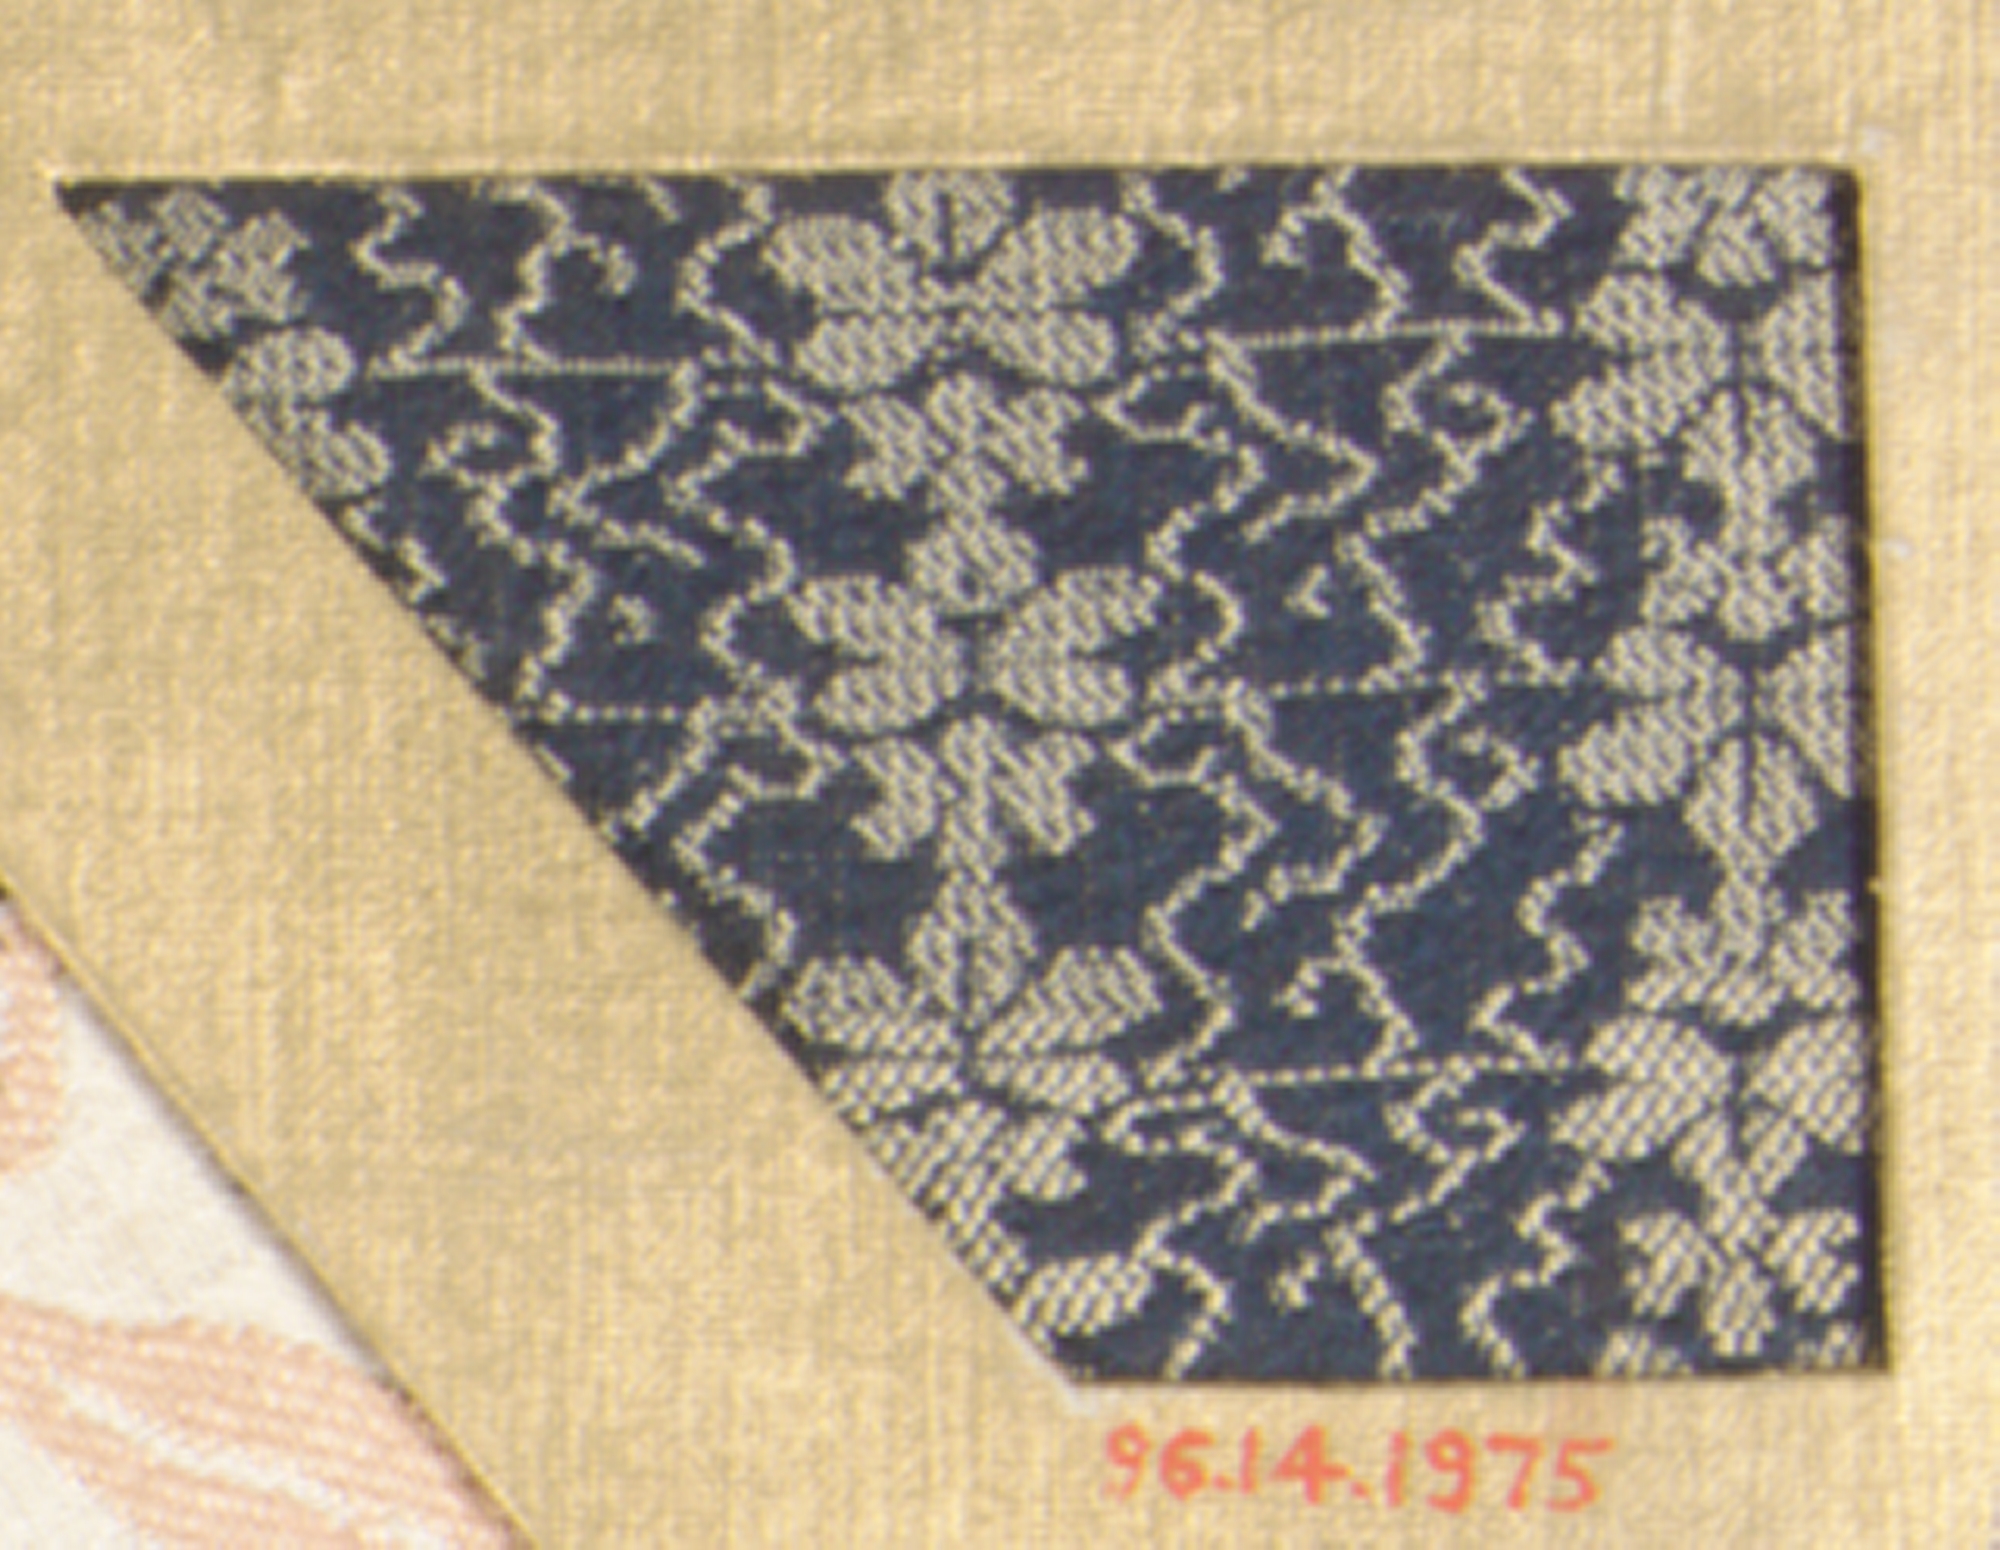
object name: piece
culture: japanese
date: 1701-1900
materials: silk